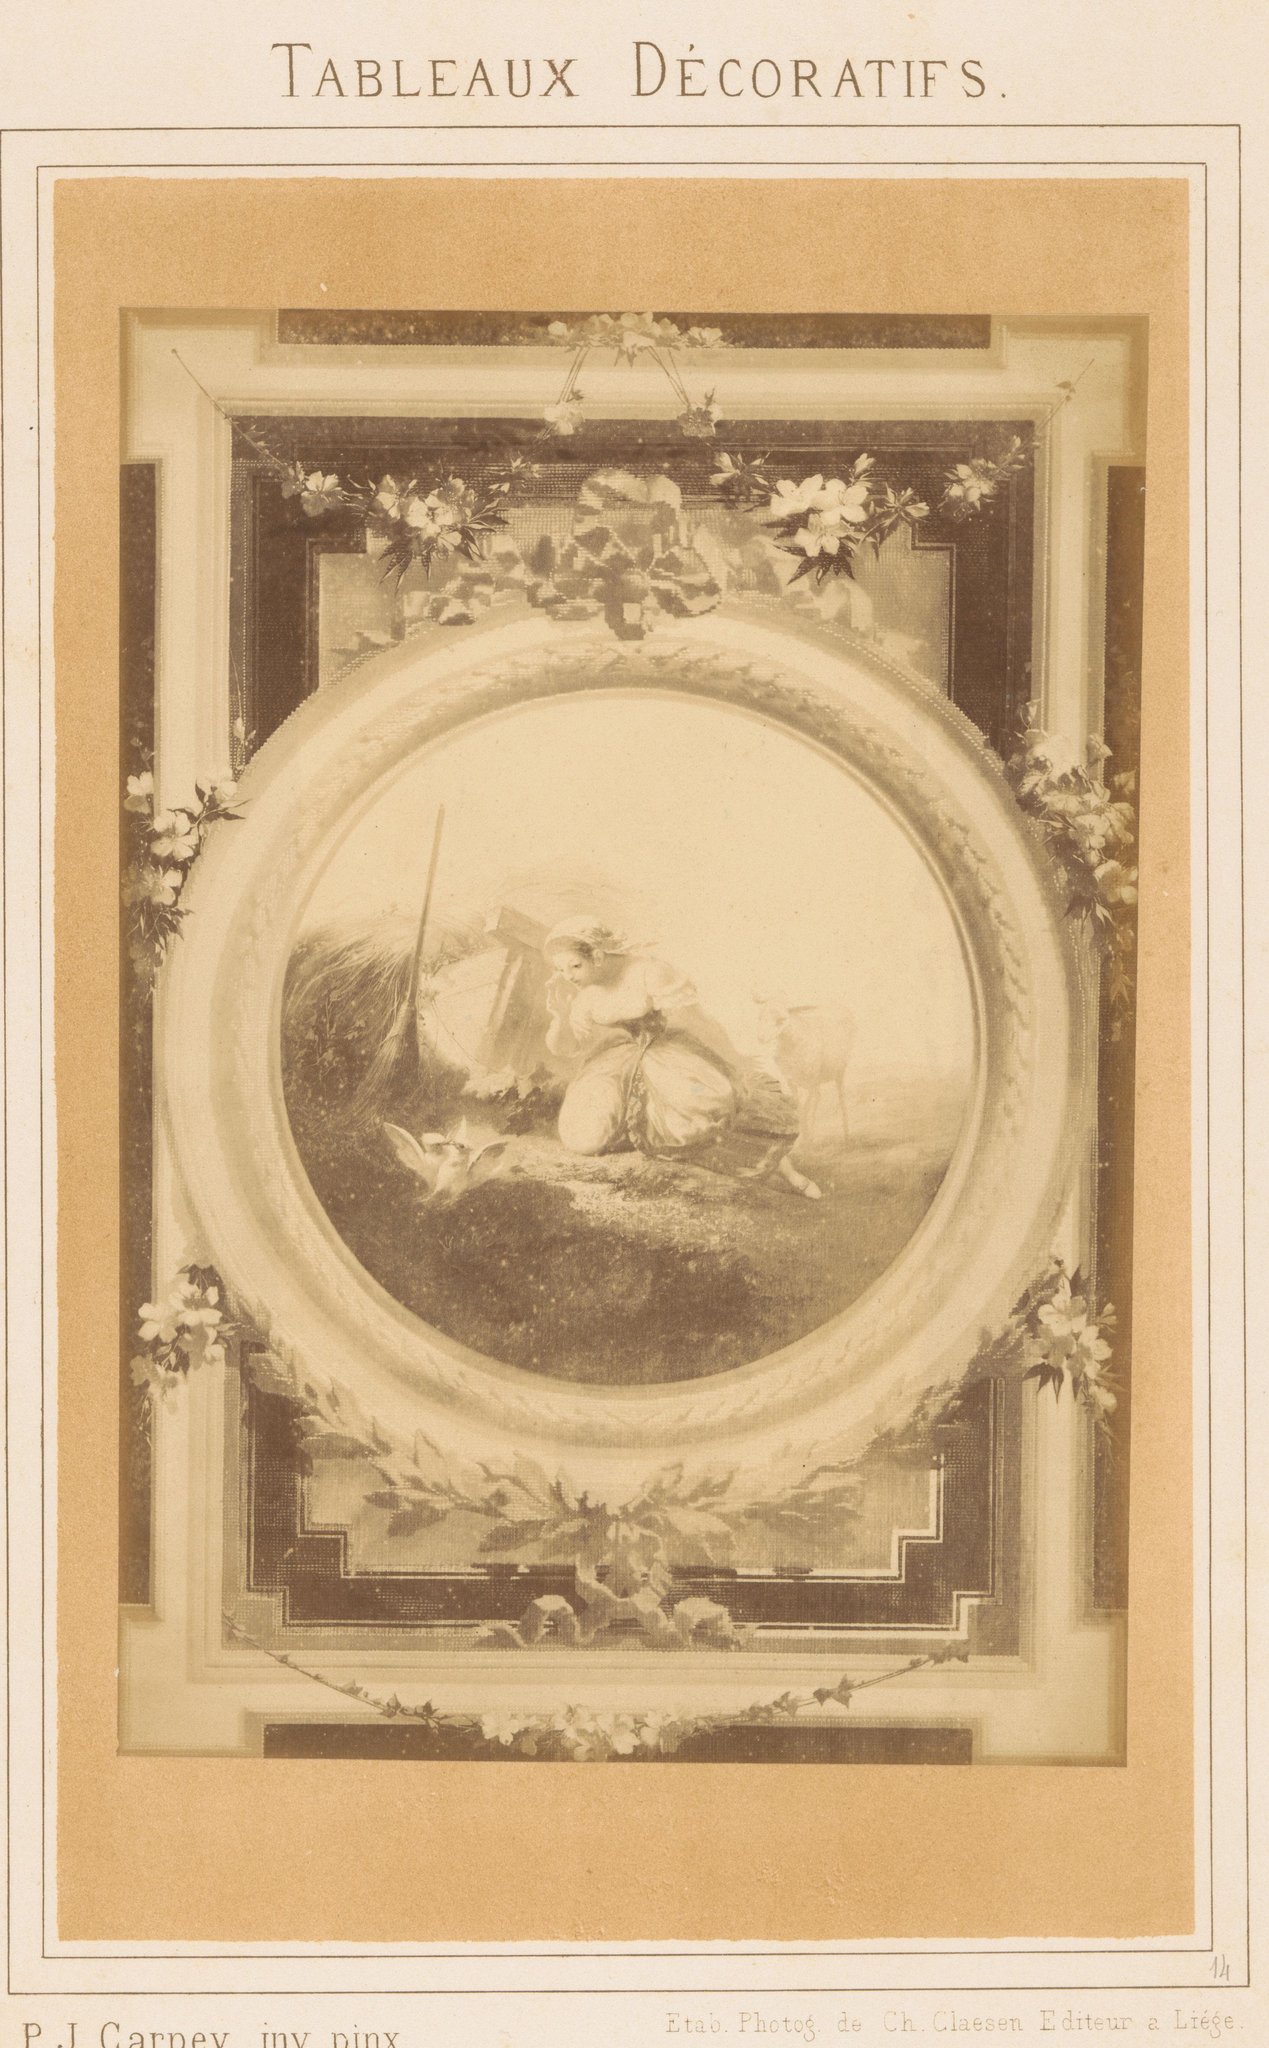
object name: reproduction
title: Tableaux Décoratifs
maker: paul-joseph carpay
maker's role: painter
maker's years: 1822-1892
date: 1874-1881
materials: photographic support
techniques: albumen print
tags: adult woman, birds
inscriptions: inscription: ‘Etab. Photog. de Ch. Claesen Editeur a Liége.’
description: Deze foto maakt deel uit van een omslag met 24 foto's op 22 bladen.